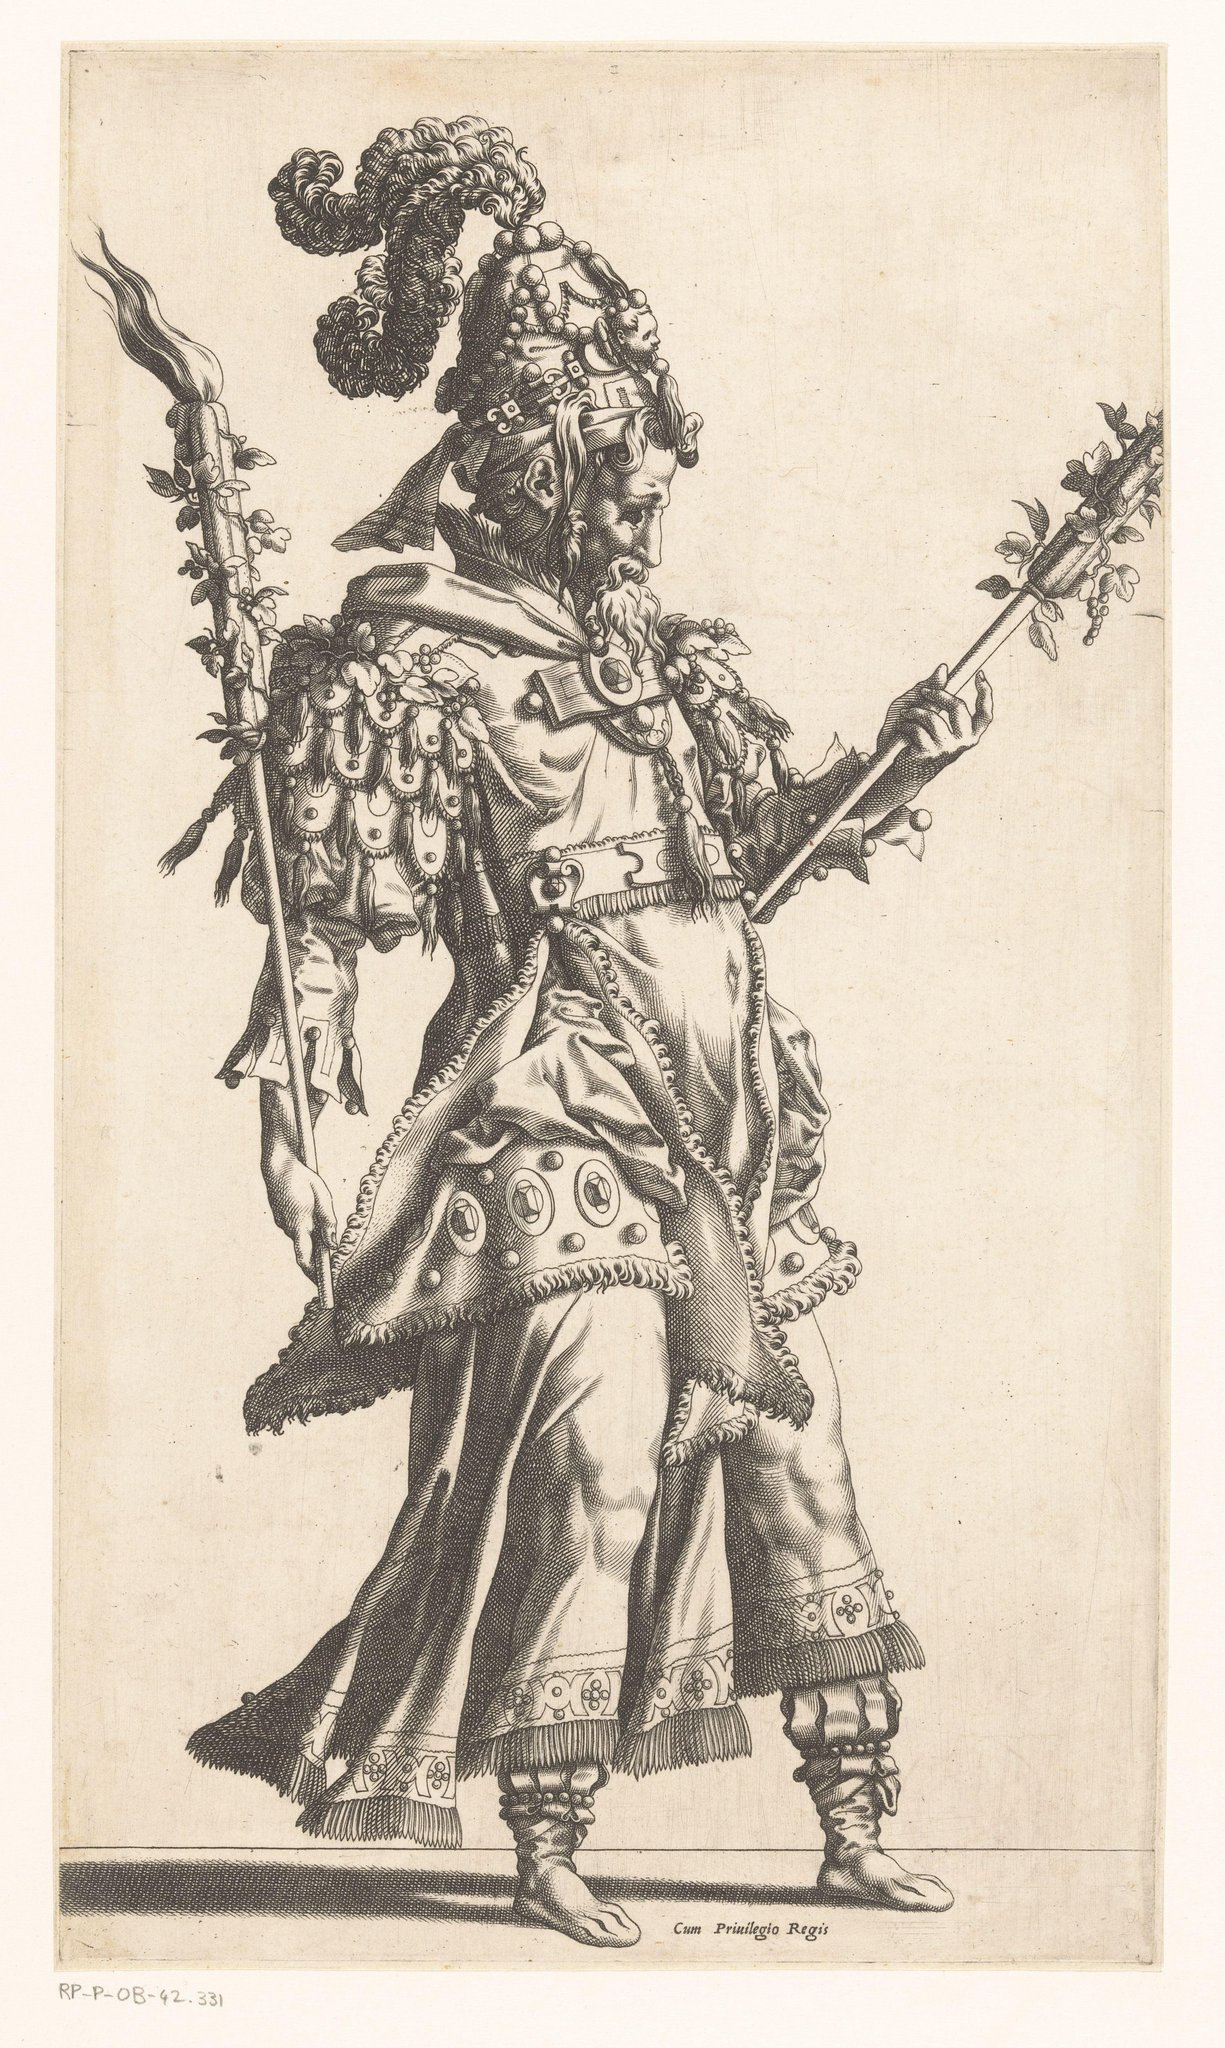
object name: print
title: Toortsdrager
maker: rené boyvin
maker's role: print maker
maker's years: 1525-1598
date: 1535-1598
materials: paper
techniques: engraving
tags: torch, head-gear, fantasy costume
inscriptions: collector's mark: Lugt 240